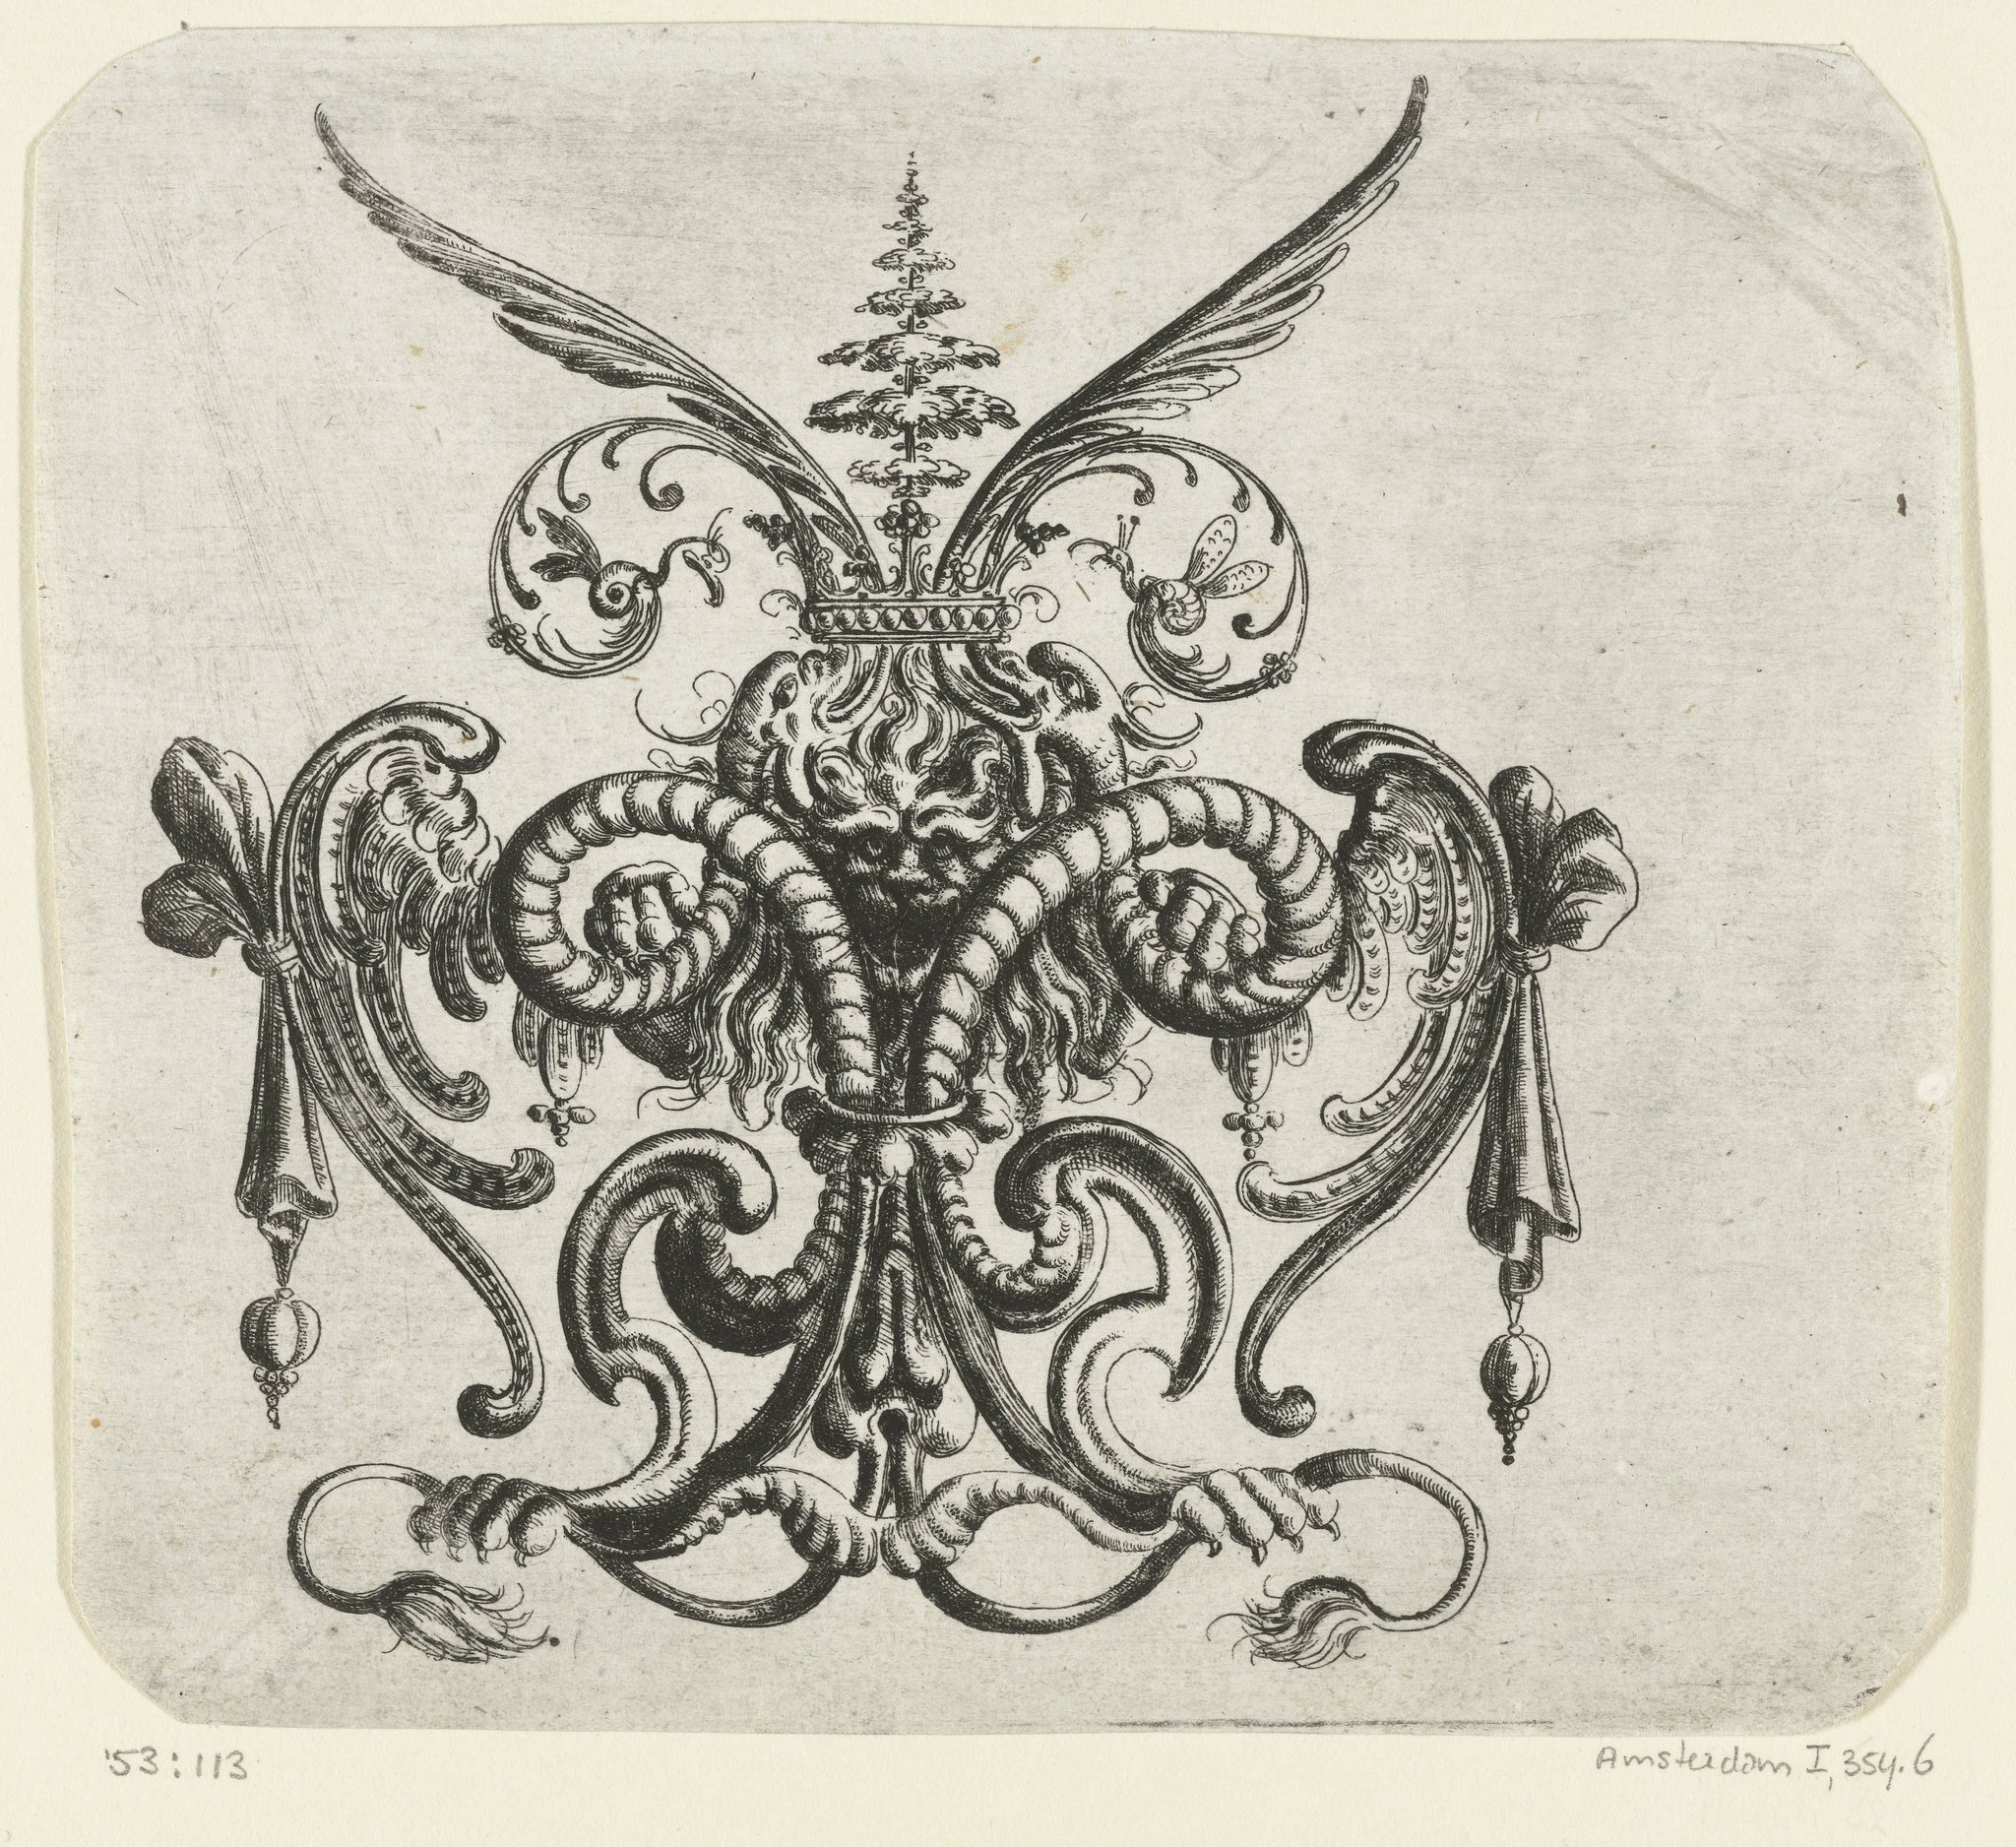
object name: print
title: Das Neuw Grottesken Buch Nürnberg 1610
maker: christoph jamnitzer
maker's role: draughtsman, goldsmith, print maker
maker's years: 1563-1618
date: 1573-1610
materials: paper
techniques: etching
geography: germany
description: De leeuw draagt op zijn hoofd een kroon met een boom tussen twee palmbladeren en twee voluten van bladranken. Blad uit een serie vlakdecoraties met grotesken, cartouches, ovalen, mascarons, putti en fantastische wezens. De serie bestaat uit drie titelbladen, twee tekstbladen met de opdracht en het voorwoord en 60 bladen, verdeeld over drie boeken.